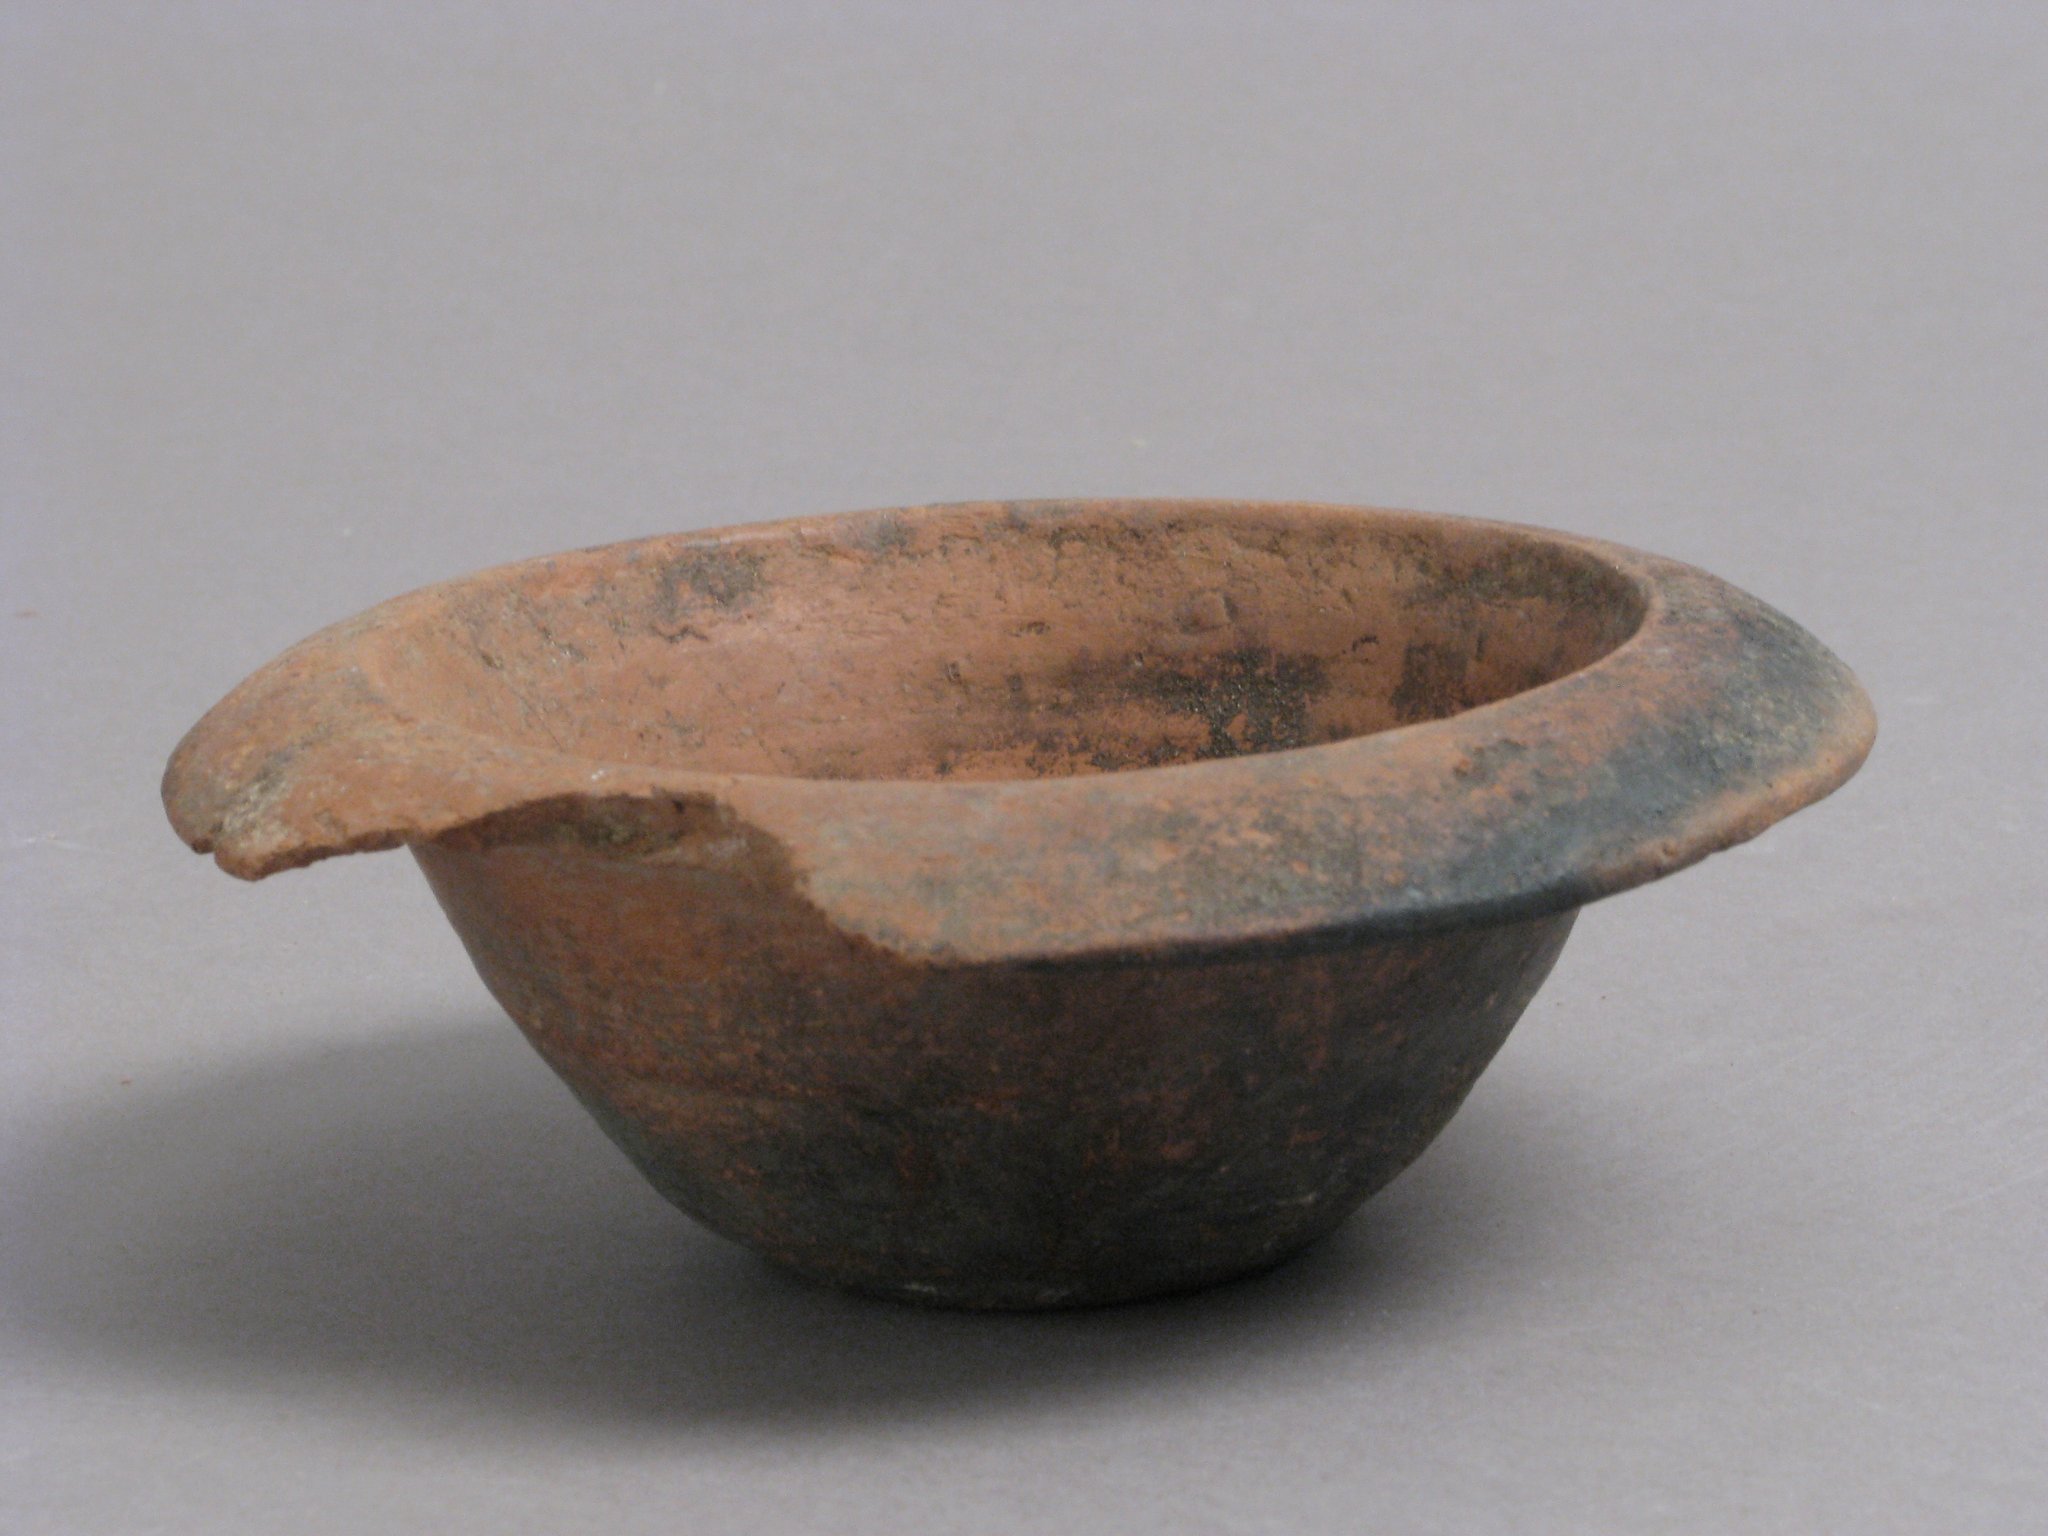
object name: bowl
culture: coptic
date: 301-700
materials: earthenware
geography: egypt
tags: bowls